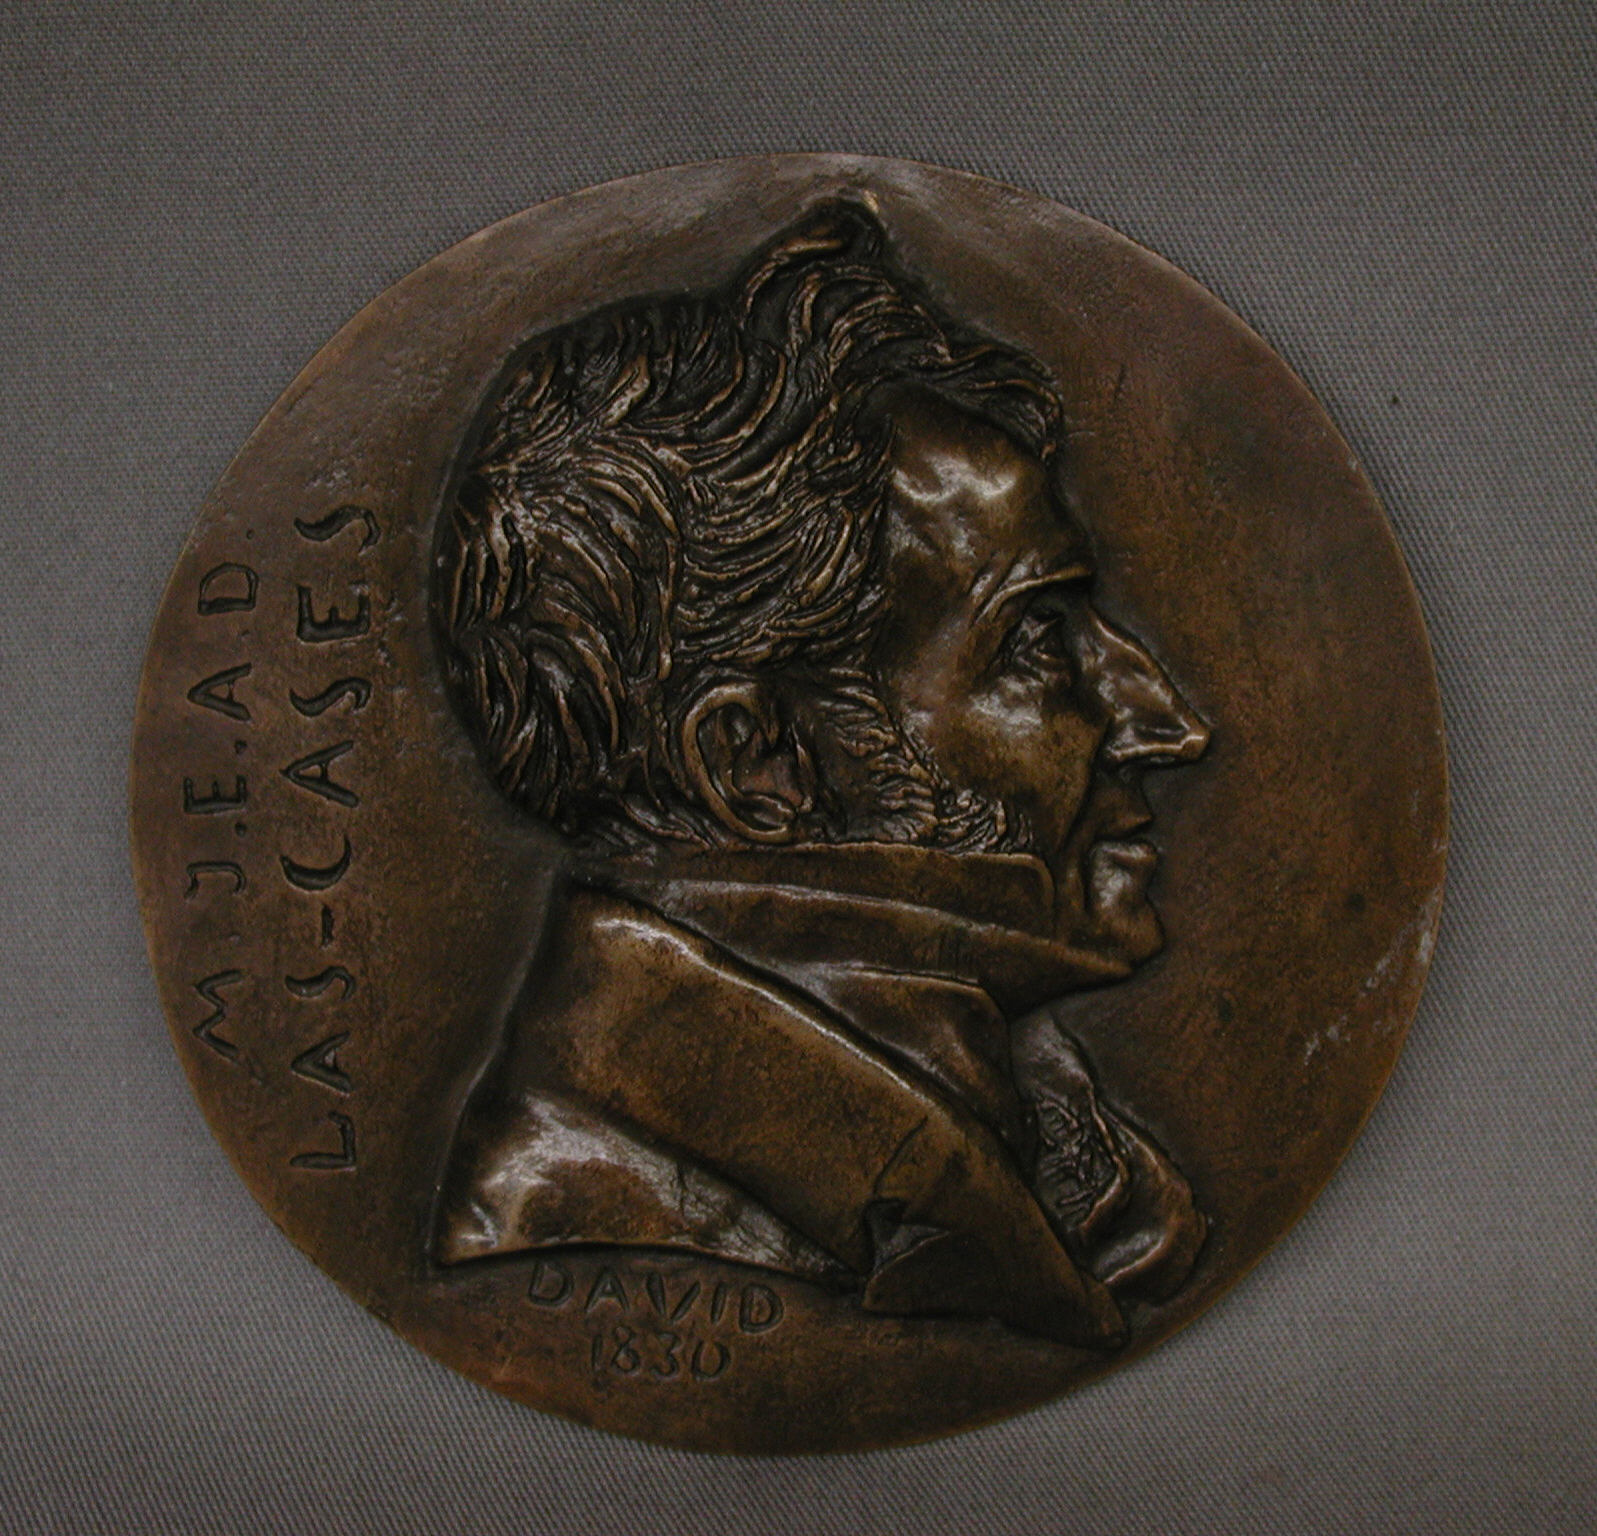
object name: medallion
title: Emmanuel-Augustin-Dieudonné-Marin-Joseph, comte de Las Cases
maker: pierre jean david d'angers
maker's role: maker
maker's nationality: french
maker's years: 1788-1856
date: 1830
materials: bronze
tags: men,profiles